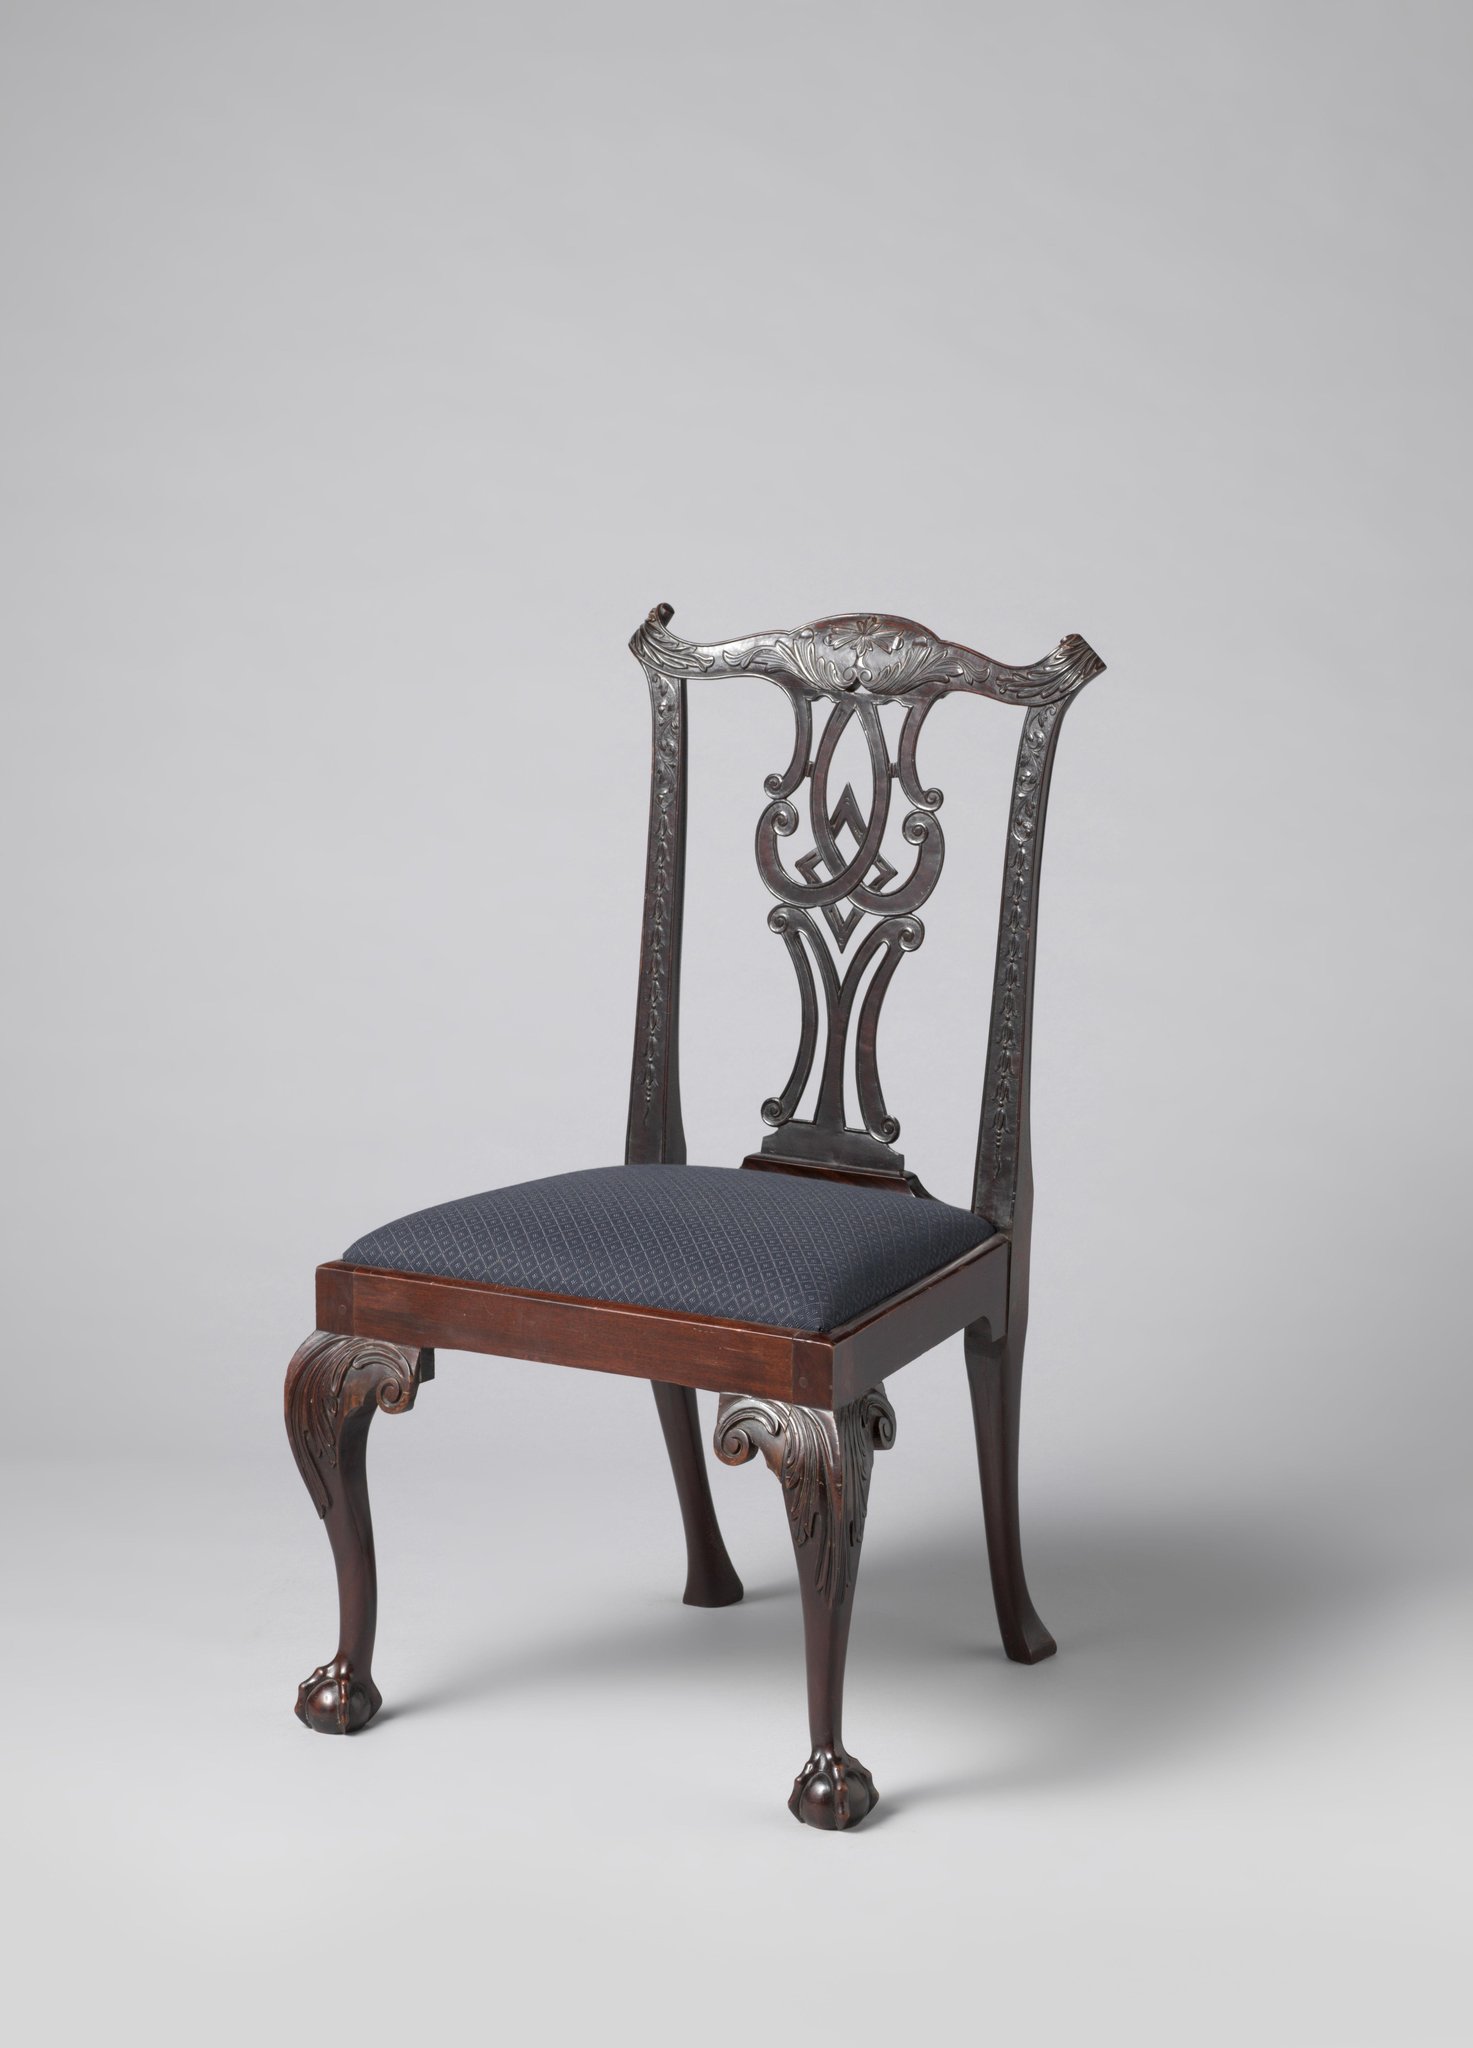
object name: suite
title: Meubilair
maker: Anonymous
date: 1700-1800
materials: leather, wood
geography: great britain